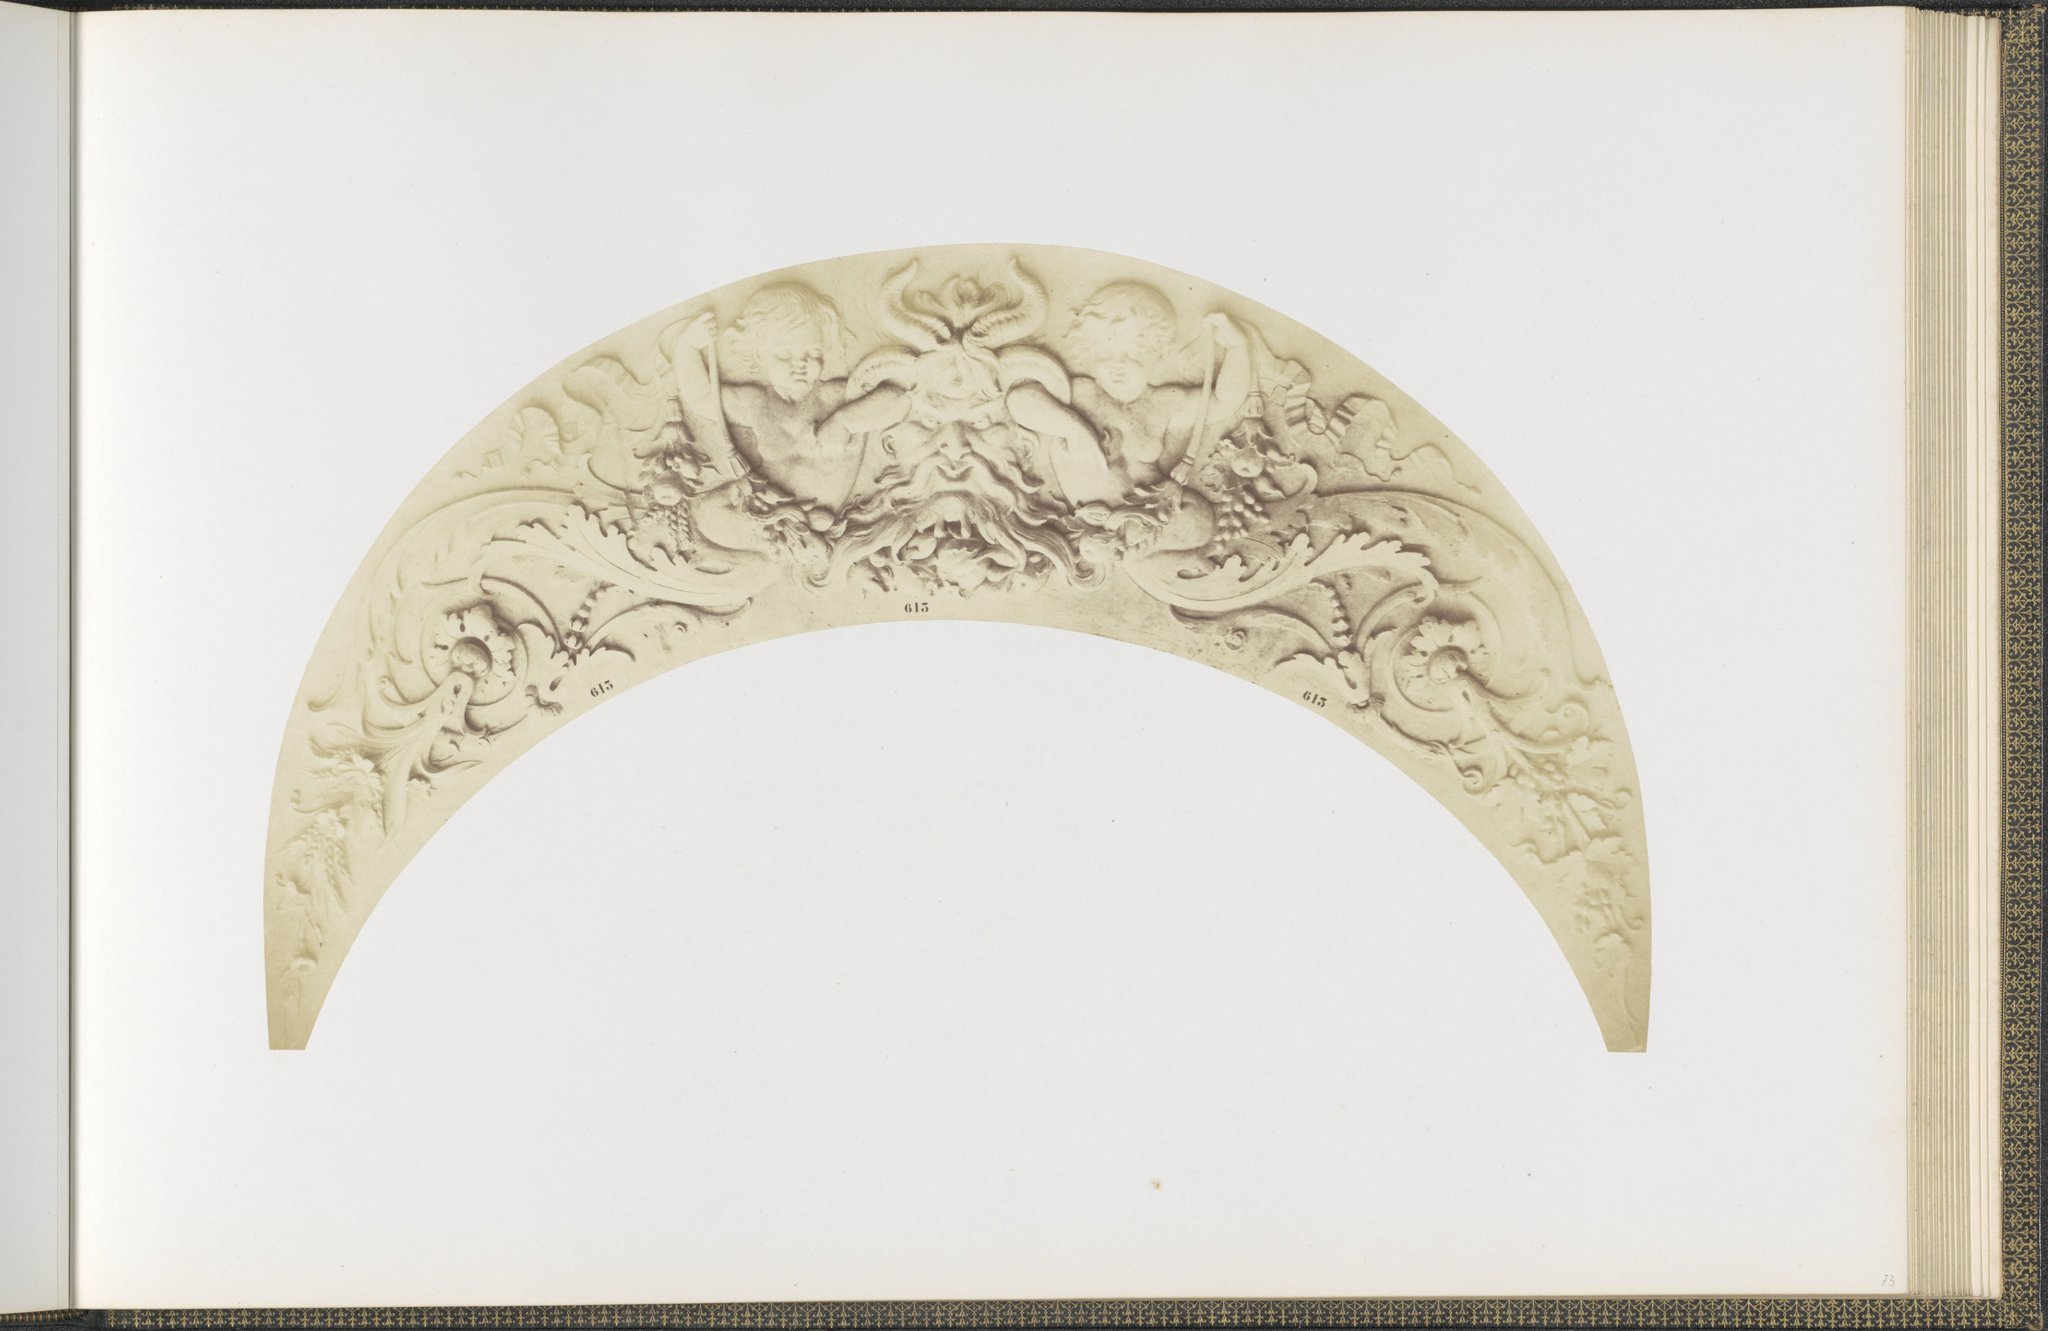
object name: photograph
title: Gipsmodel voor een gewelfversiering van het Palais du Louvre door Jean-Baptiste Revillon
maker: édouard denis baldus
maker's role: fotograaf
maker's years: 1813-1889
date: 1855-1857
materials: paper, photographic support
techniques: salted paper print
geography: paris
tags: permanent exhibition, museum, ornamenting, decorating ~ applied arts, paris, tuileries palace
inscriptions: number: ‘589’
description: Onderdeel van Réunion des Tuileries au Louvre 1852-1857, album 4.